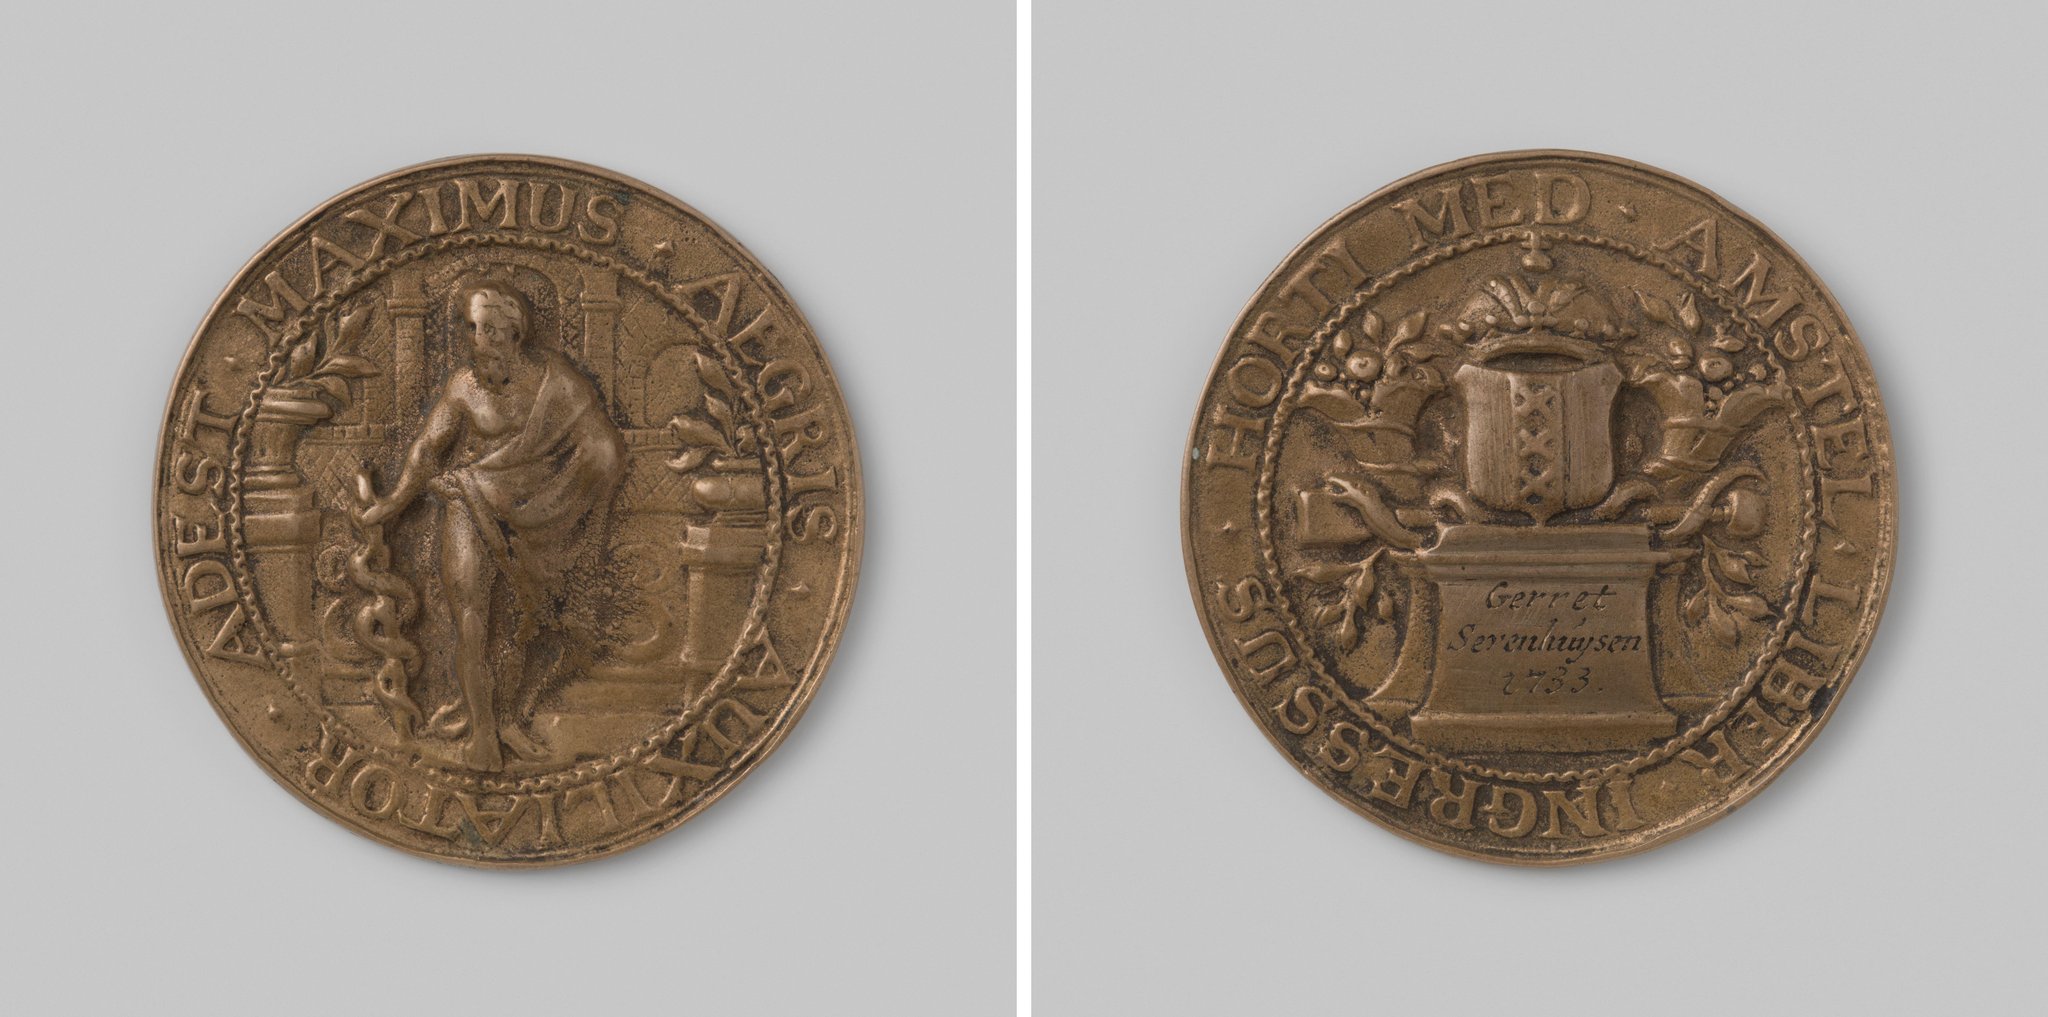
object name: medal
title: Toegangspenning tot de Hortus Medicus te Amsterdam 1696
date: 1696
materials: brass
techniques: casting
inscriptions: circumscription: ‘MAXIMUS AEGRIS AUXILIATOR ADEST’, circumscription: ‘HORTI MED AMSTEL LIBER INGRESSUS’, inscription: ‘Gerret / Sevenhuysen / 1733’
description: Gegoten messing penning met op de voorzijde Aesculapius en op de keerzijde een altaar waarop het gekroonde stadswapen, een caduceus en cornucopiae waaruit kruidentakken, op naam van Gerret Sevenhuysen 1733